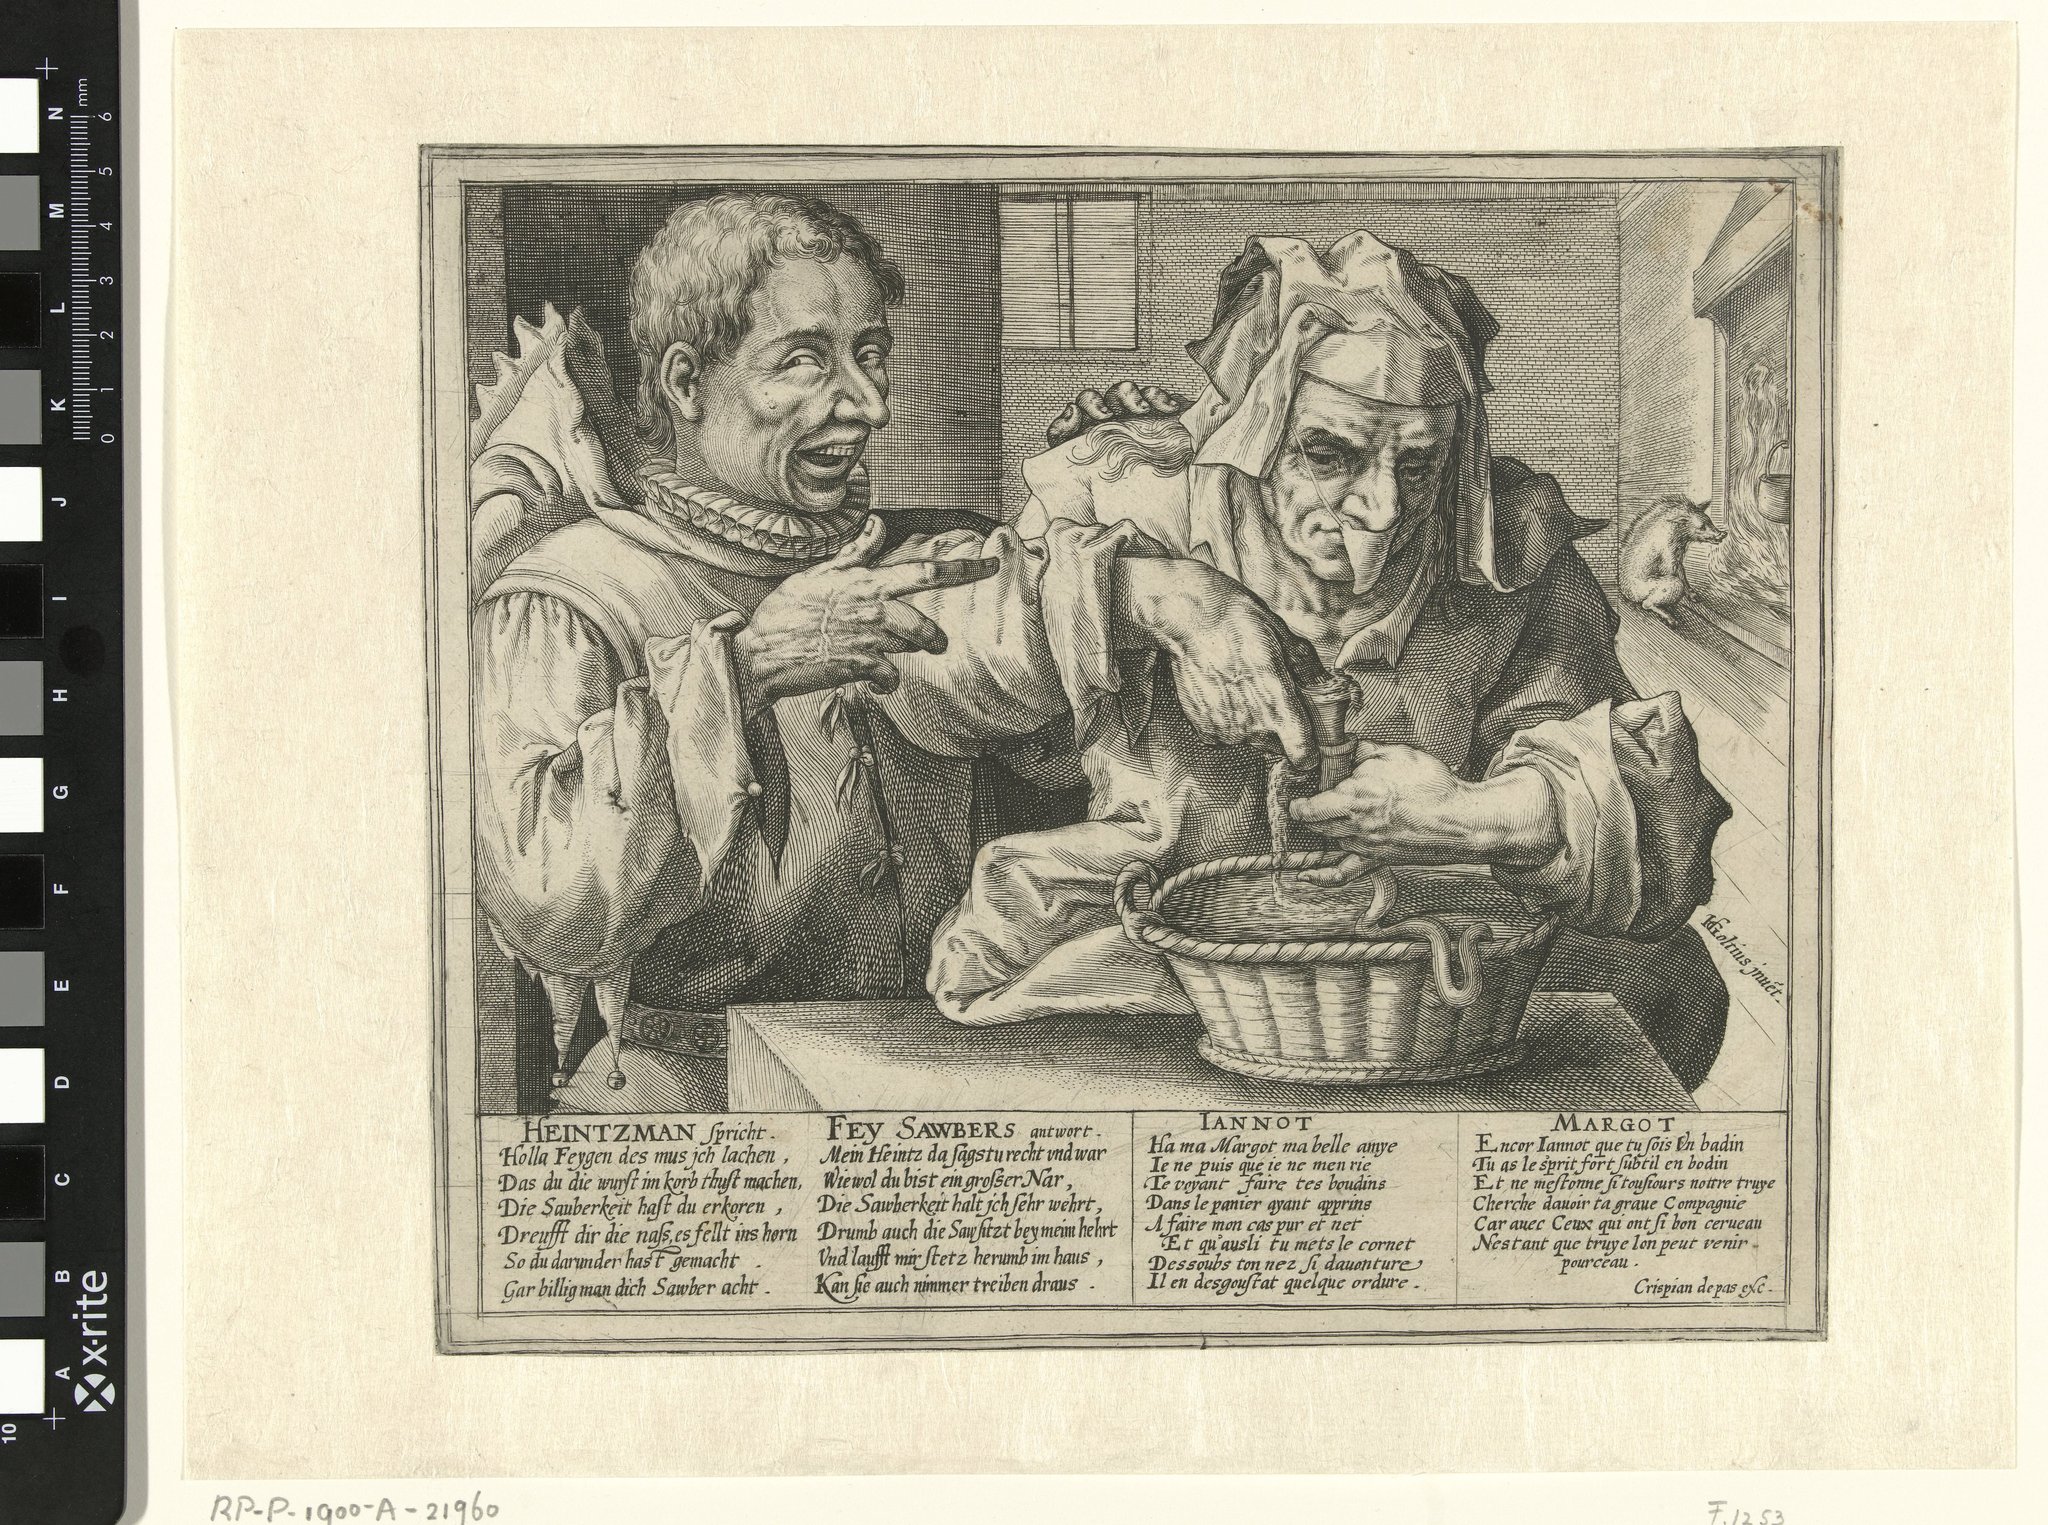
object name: print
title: Satire op hygiëne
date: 1574-1637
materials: paper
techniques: engraving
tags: political caricatures and satires (+ variant), fool, simpleton, numskull, mocking, insulting; teasing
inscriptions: collector's mark: Lugt 2228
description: Interieur met een oude vrouw (Fey Sawbers/Margot) die worst maakt. Ze draagt uit hygiënisch oogpunt een kapje om haar neus. Een man (Heintzman/Jannot) met een zotskap wijst naar haar en lacht uitbundig om het feit dat ze met het kapje probeert te voorkomen dat er een druppel uit haar neus op de worst valt. Op de achtergrond een everzwijn dat zich aan een haardvuur warmt. In de marge een veertienregelig gedicht in dialoogvorm, in het Duits en in het Frans.